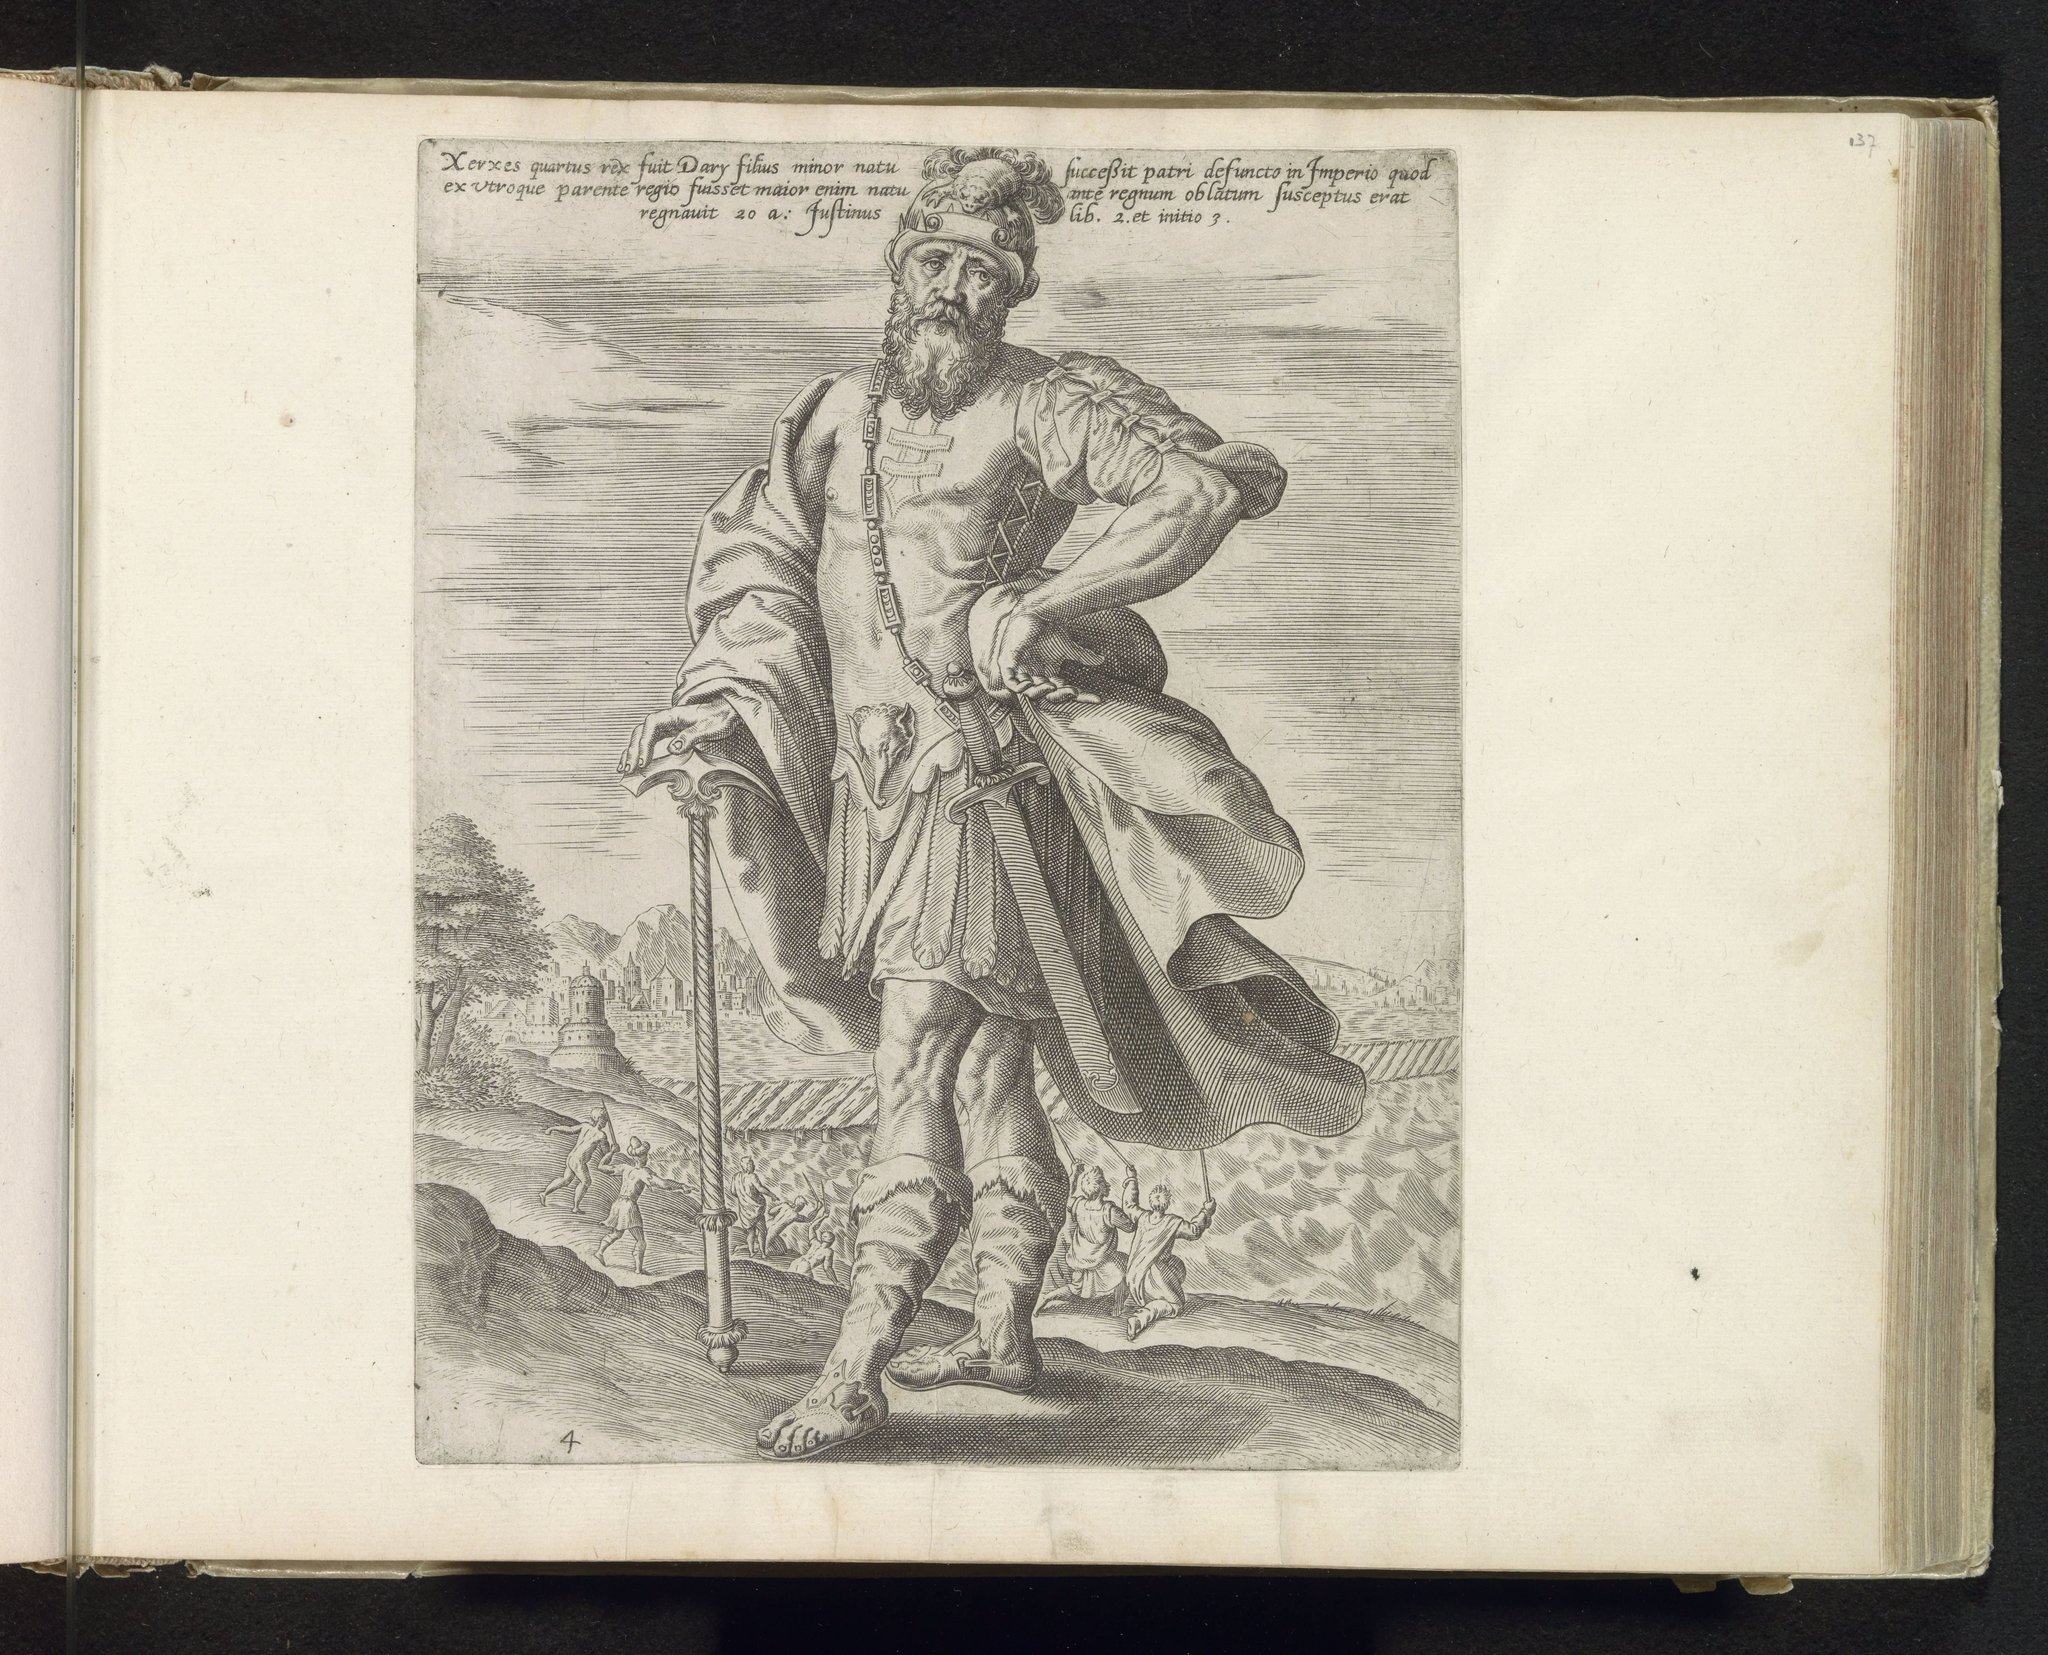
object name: print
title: Thesaurus sacrarum historiaru[m] veteris testame[n]ti, elega[n]tissimis imaginibus expressu[m] excelle[n]tissimoru[m] in hac arte viroru[m] opera: nu[n]c primu[m] in luce[m] editus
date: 1585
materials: paper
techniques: engraving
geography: antwerp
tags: male persons from classical history, ruler, sovereign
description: Koning Xerxes van Perzië staande met een hand op een pikhouweel. Op de achtergrond is te zien hoe de mannen van Xerxes de Hellespont zweepslagen geven. Dit deden zij in opdracht van Xerxes nadat de gebouwde bruggen over de Hellespont door storm en het water waren vernield. Boven de voorstelling een drieregelige tekst in het Latijn. Deze prent maakt deel uit van een album.